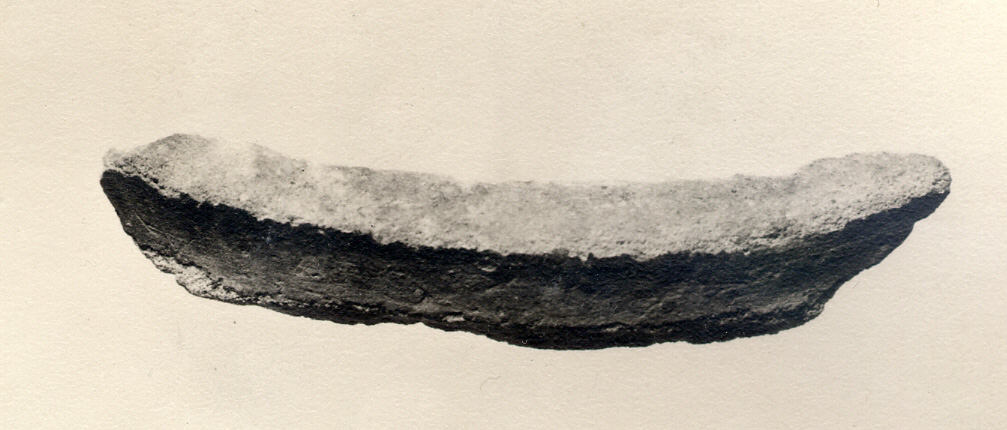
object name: fragment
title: Ceramic Fragment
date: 1401-1500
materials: earthenware, glaze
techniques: coloring, incising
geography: egypt